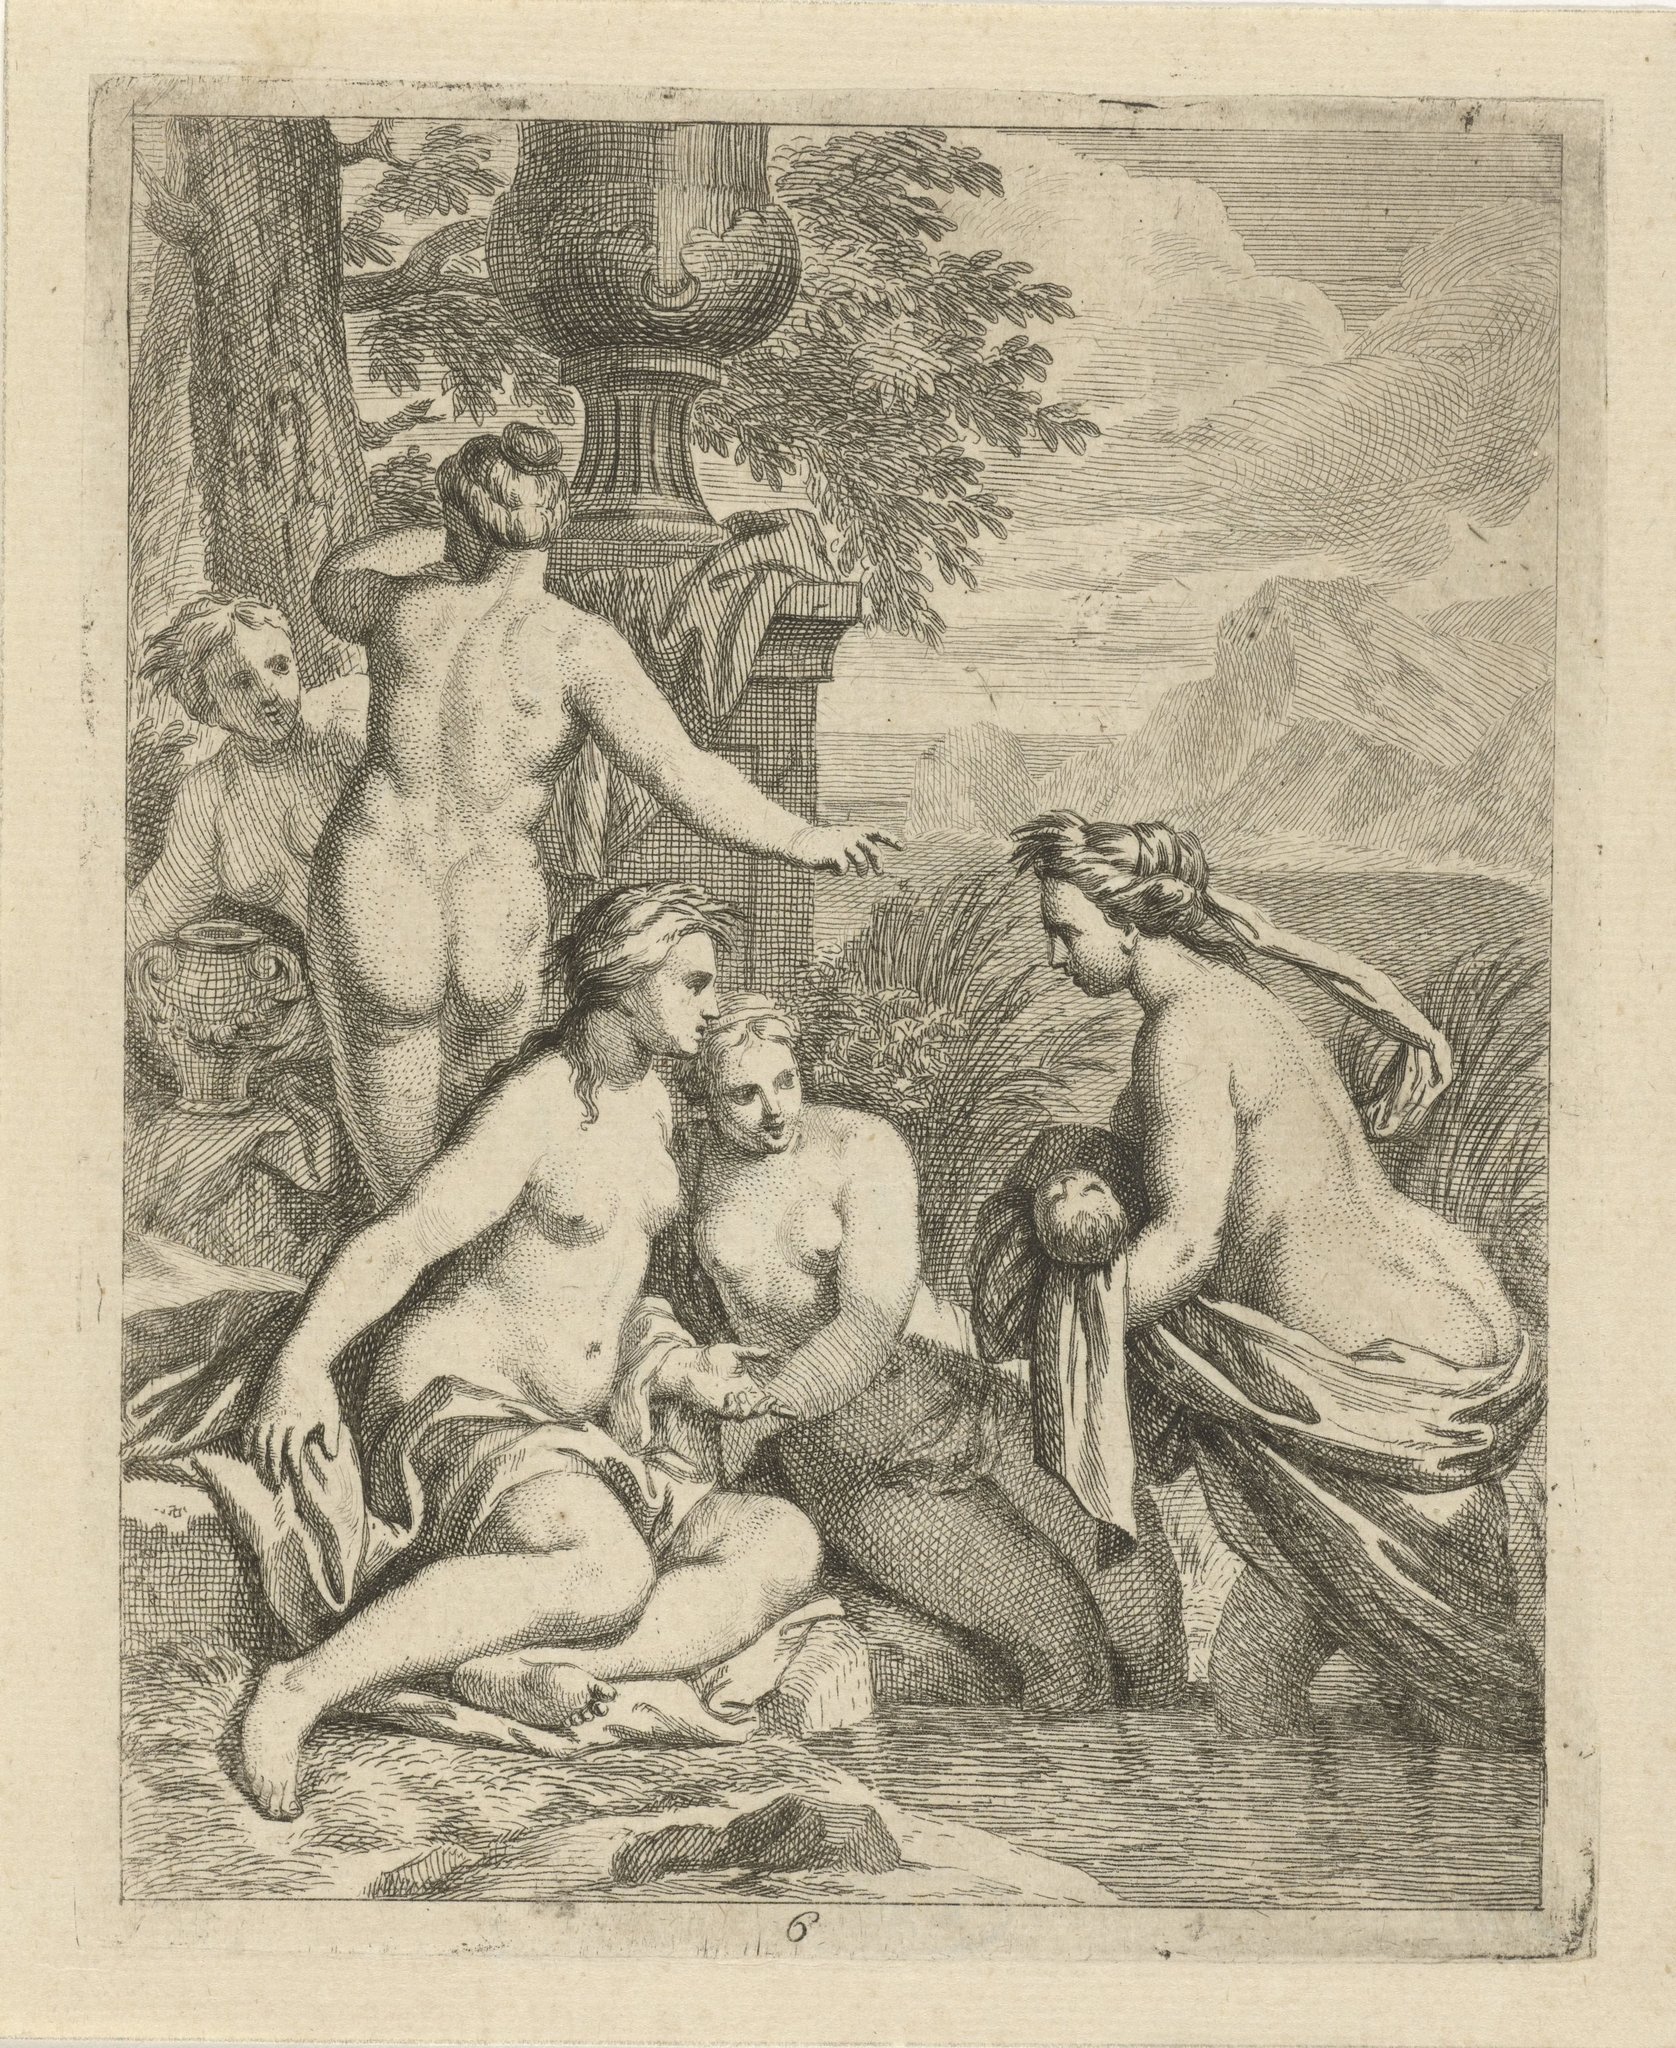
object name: print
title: Scènes uit het leven van Achilles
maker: j. alexander janssens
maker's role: print maker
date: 1700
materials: paper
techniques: engraving, etching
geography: southern netherlands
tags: thetis leaves peleus and returns to her home in the sea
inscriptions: collector's mark: Lugt 2228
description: Rivierlandschap met twee nimfen, zittend aan de oever, en Thetis met Achilles in haar armen. Achter hen twee nimfen bij een piëdestal met een klassieke vaas. Midden onder: 6. Zesde prent uit een serie van veertien met scènes uit het leven van Achilles.